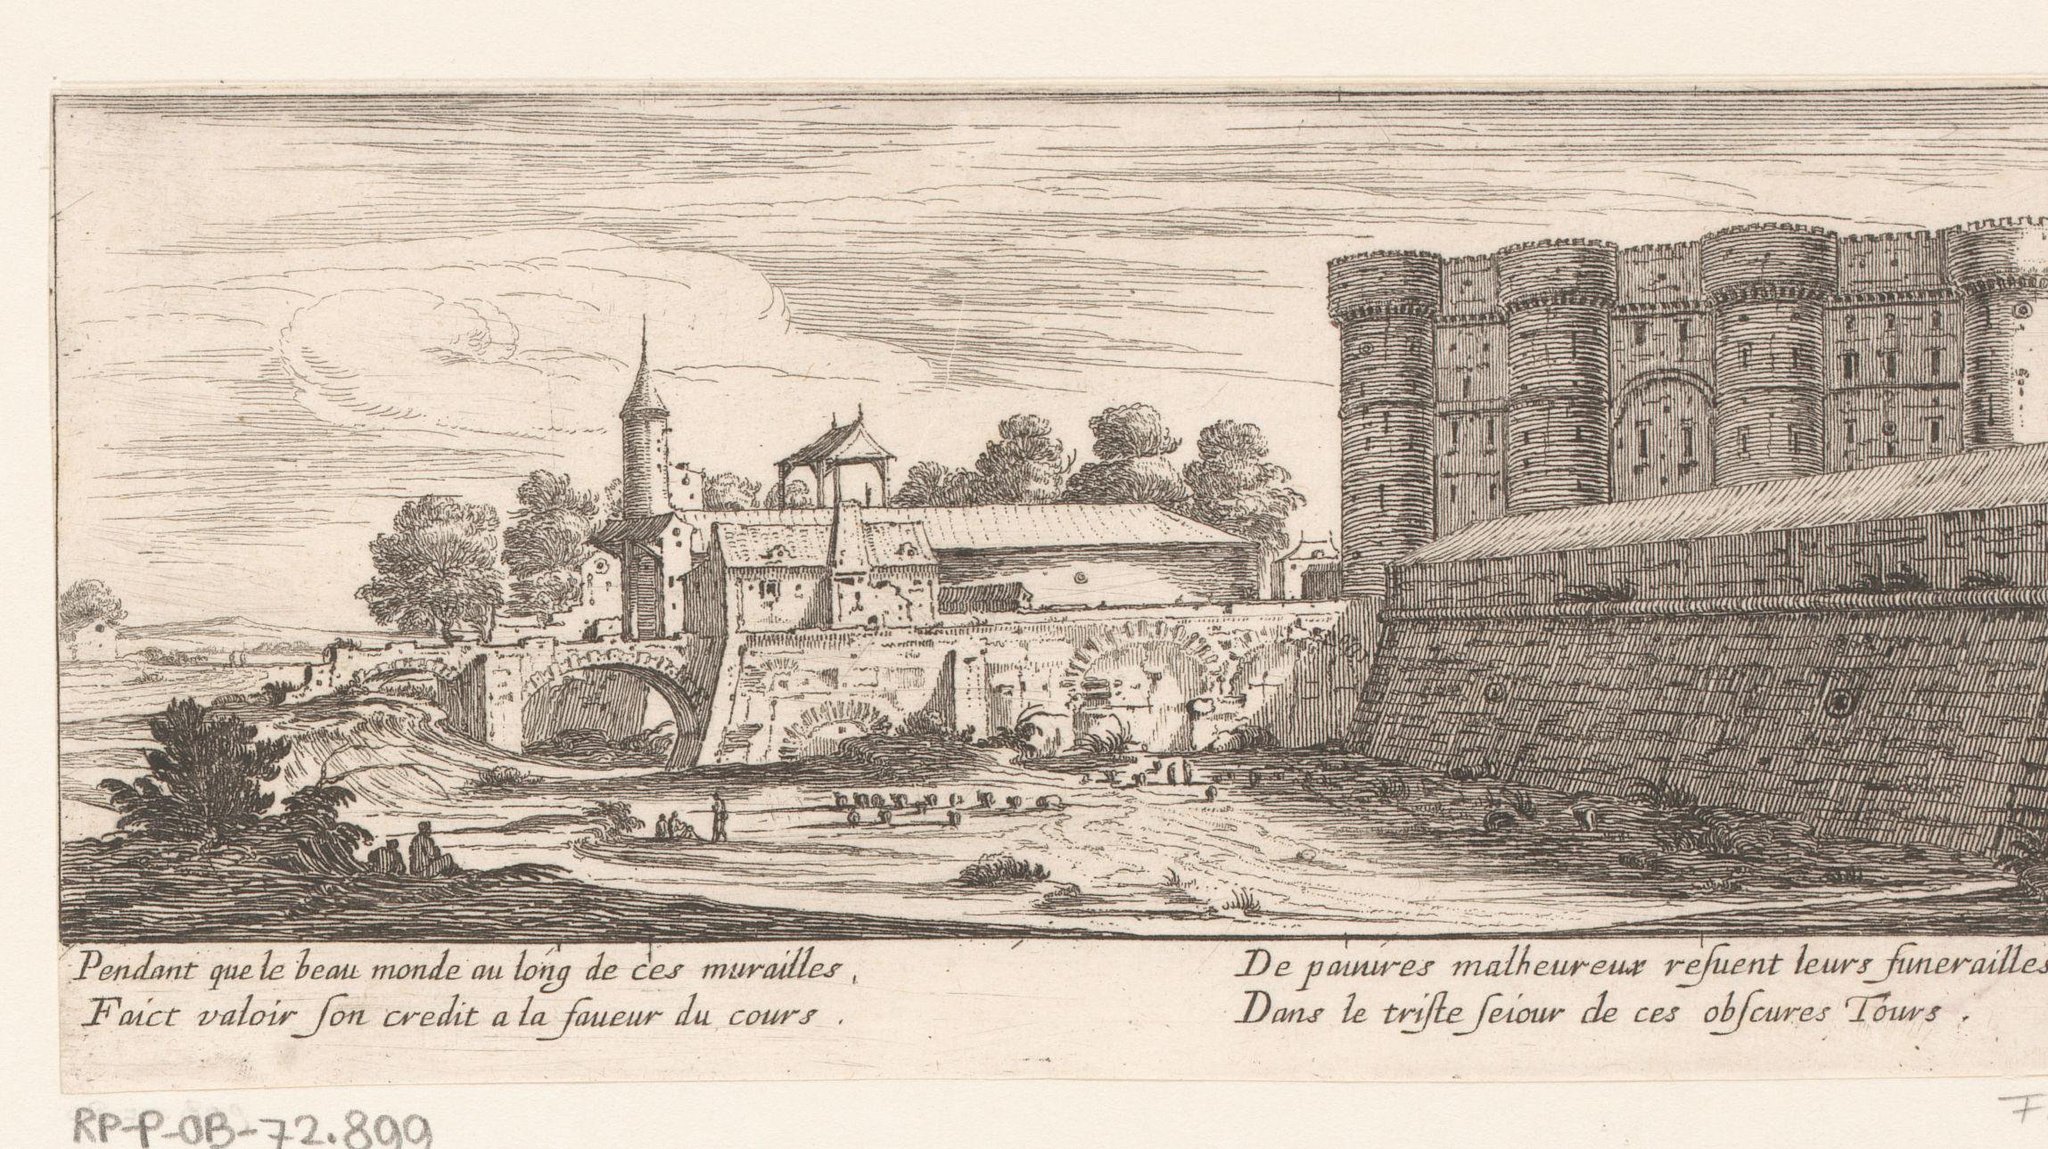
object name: print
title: Veue de la Bastille de Paris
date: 1655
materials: paper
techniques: engraving, etching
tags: prison, jail, city-view, and landscape with man-made constructions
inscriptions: collector's mark: Lugt 240